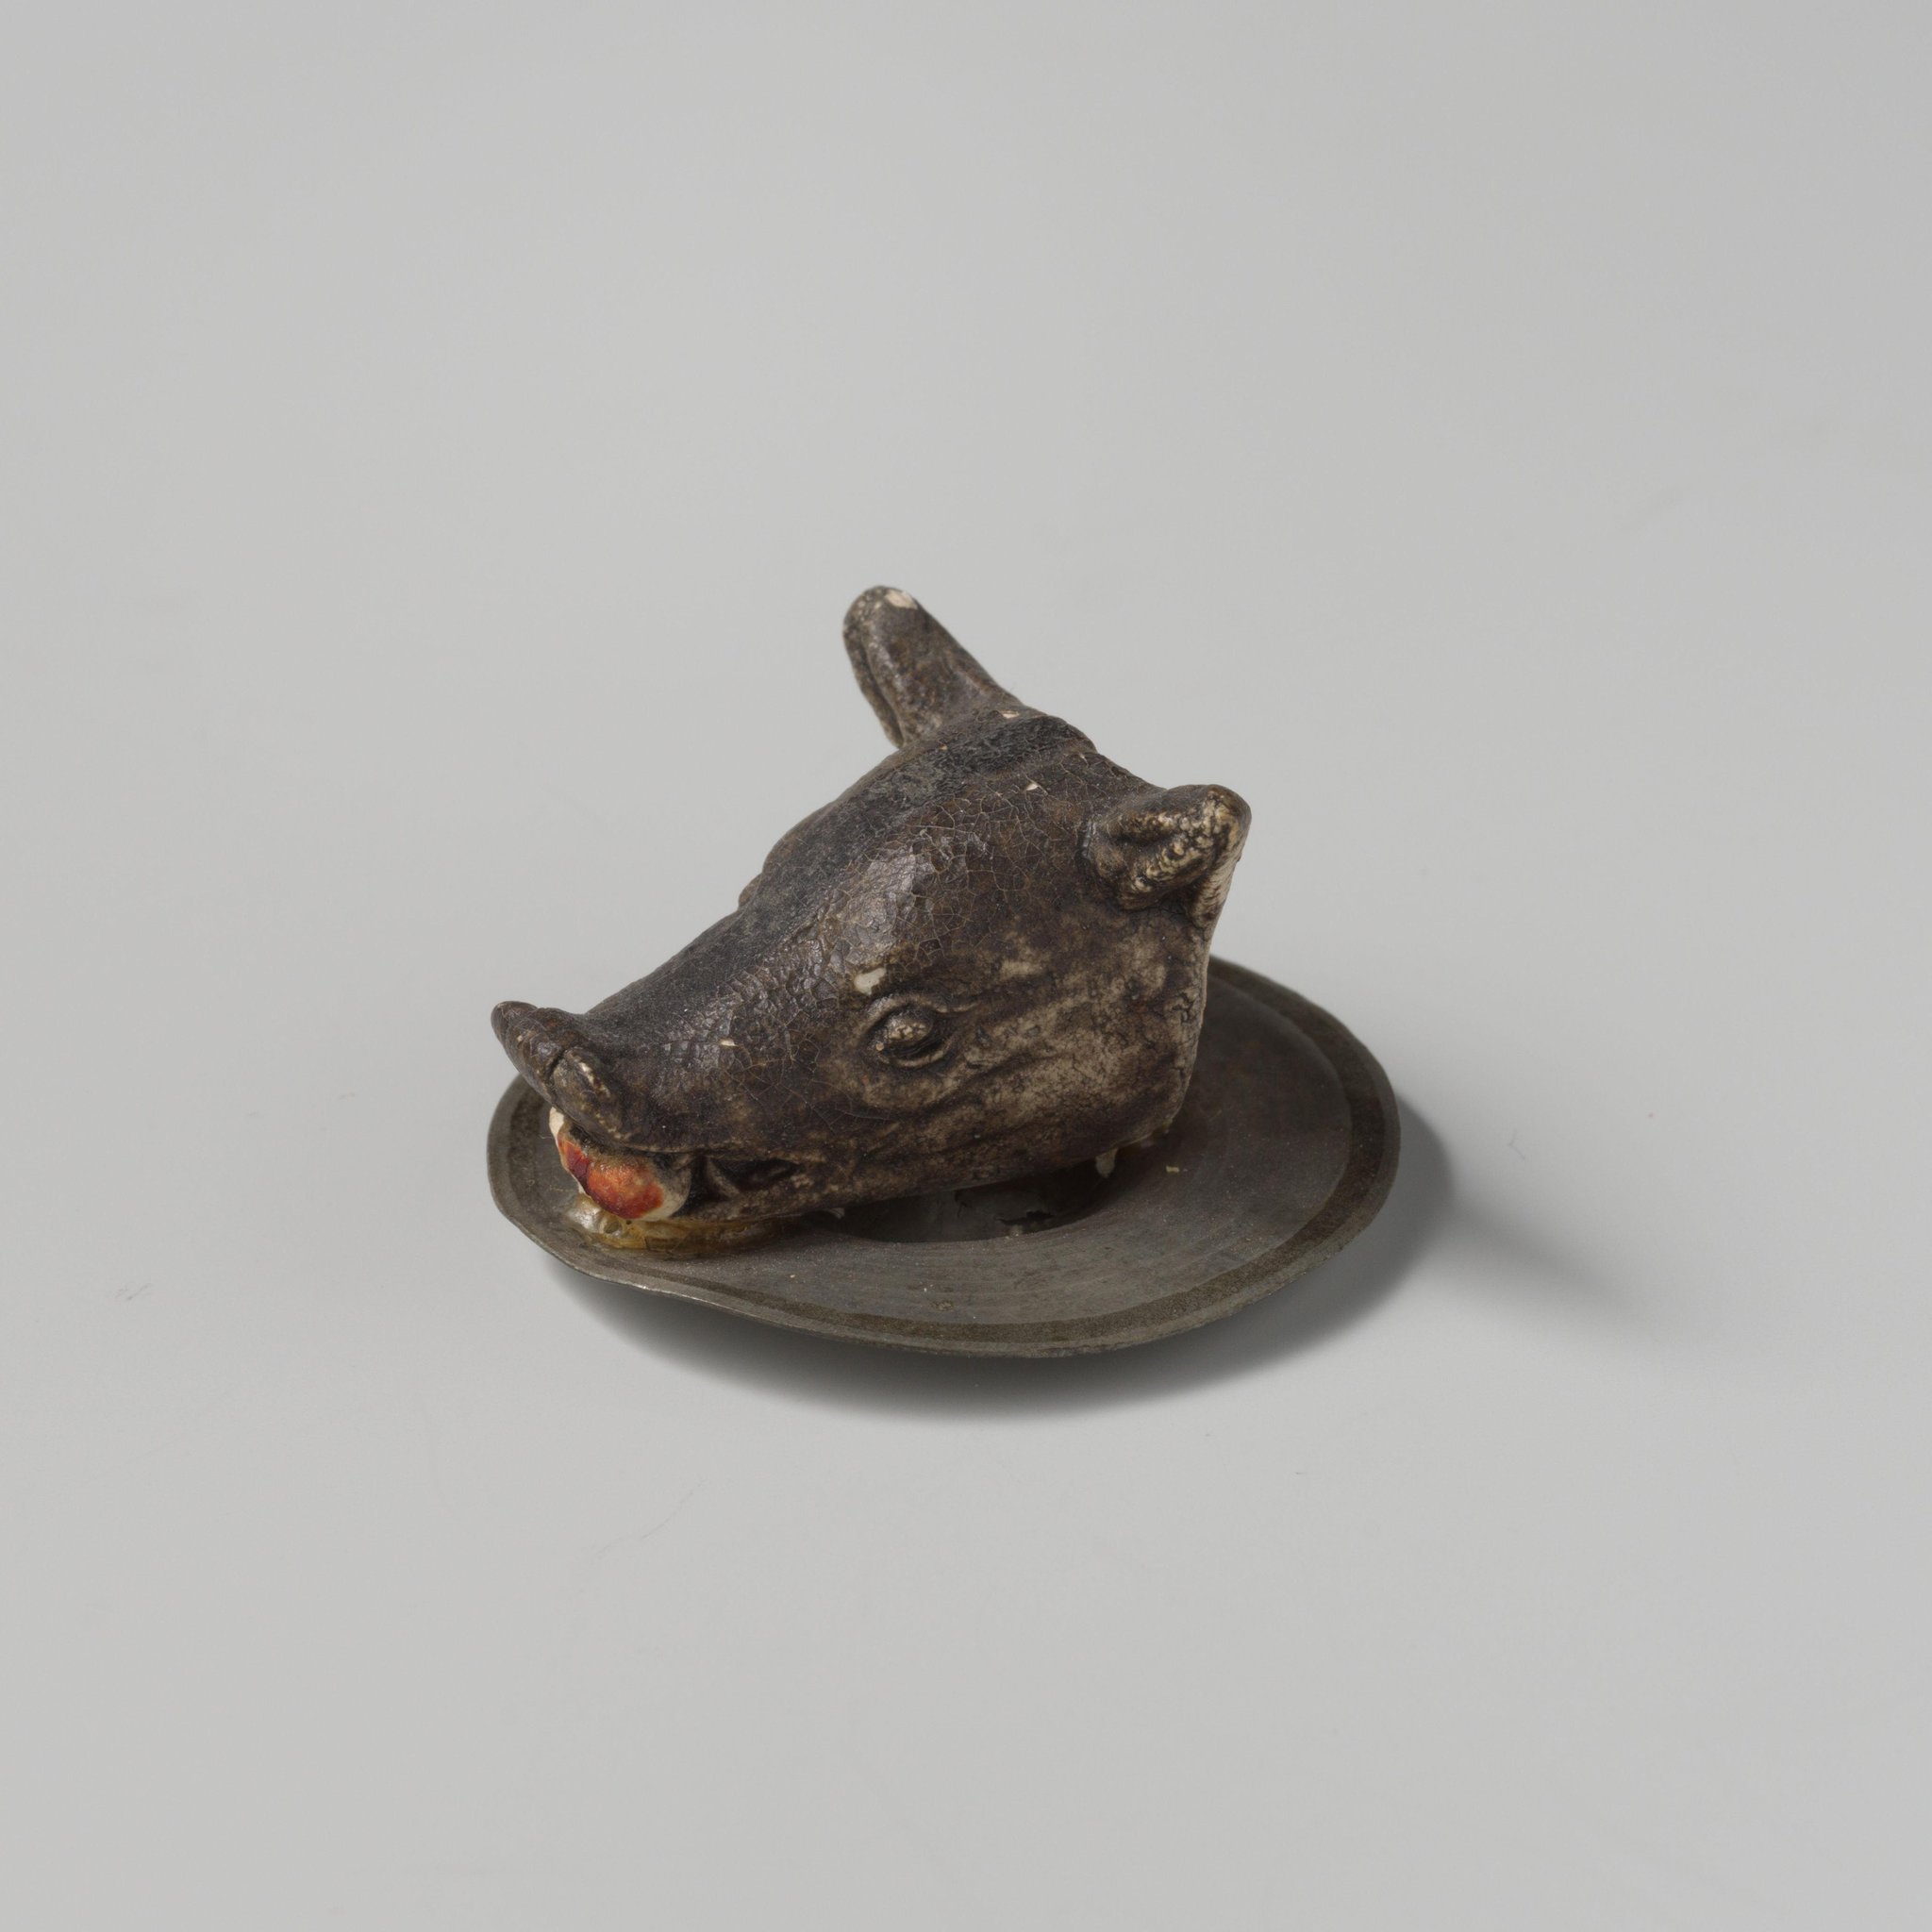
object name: food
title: Schotel met ovale pastei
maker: Anonymous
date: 1800-1899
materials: tin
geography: germany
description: Schotel, gedraaid van tin, waarop een ronde pastei.